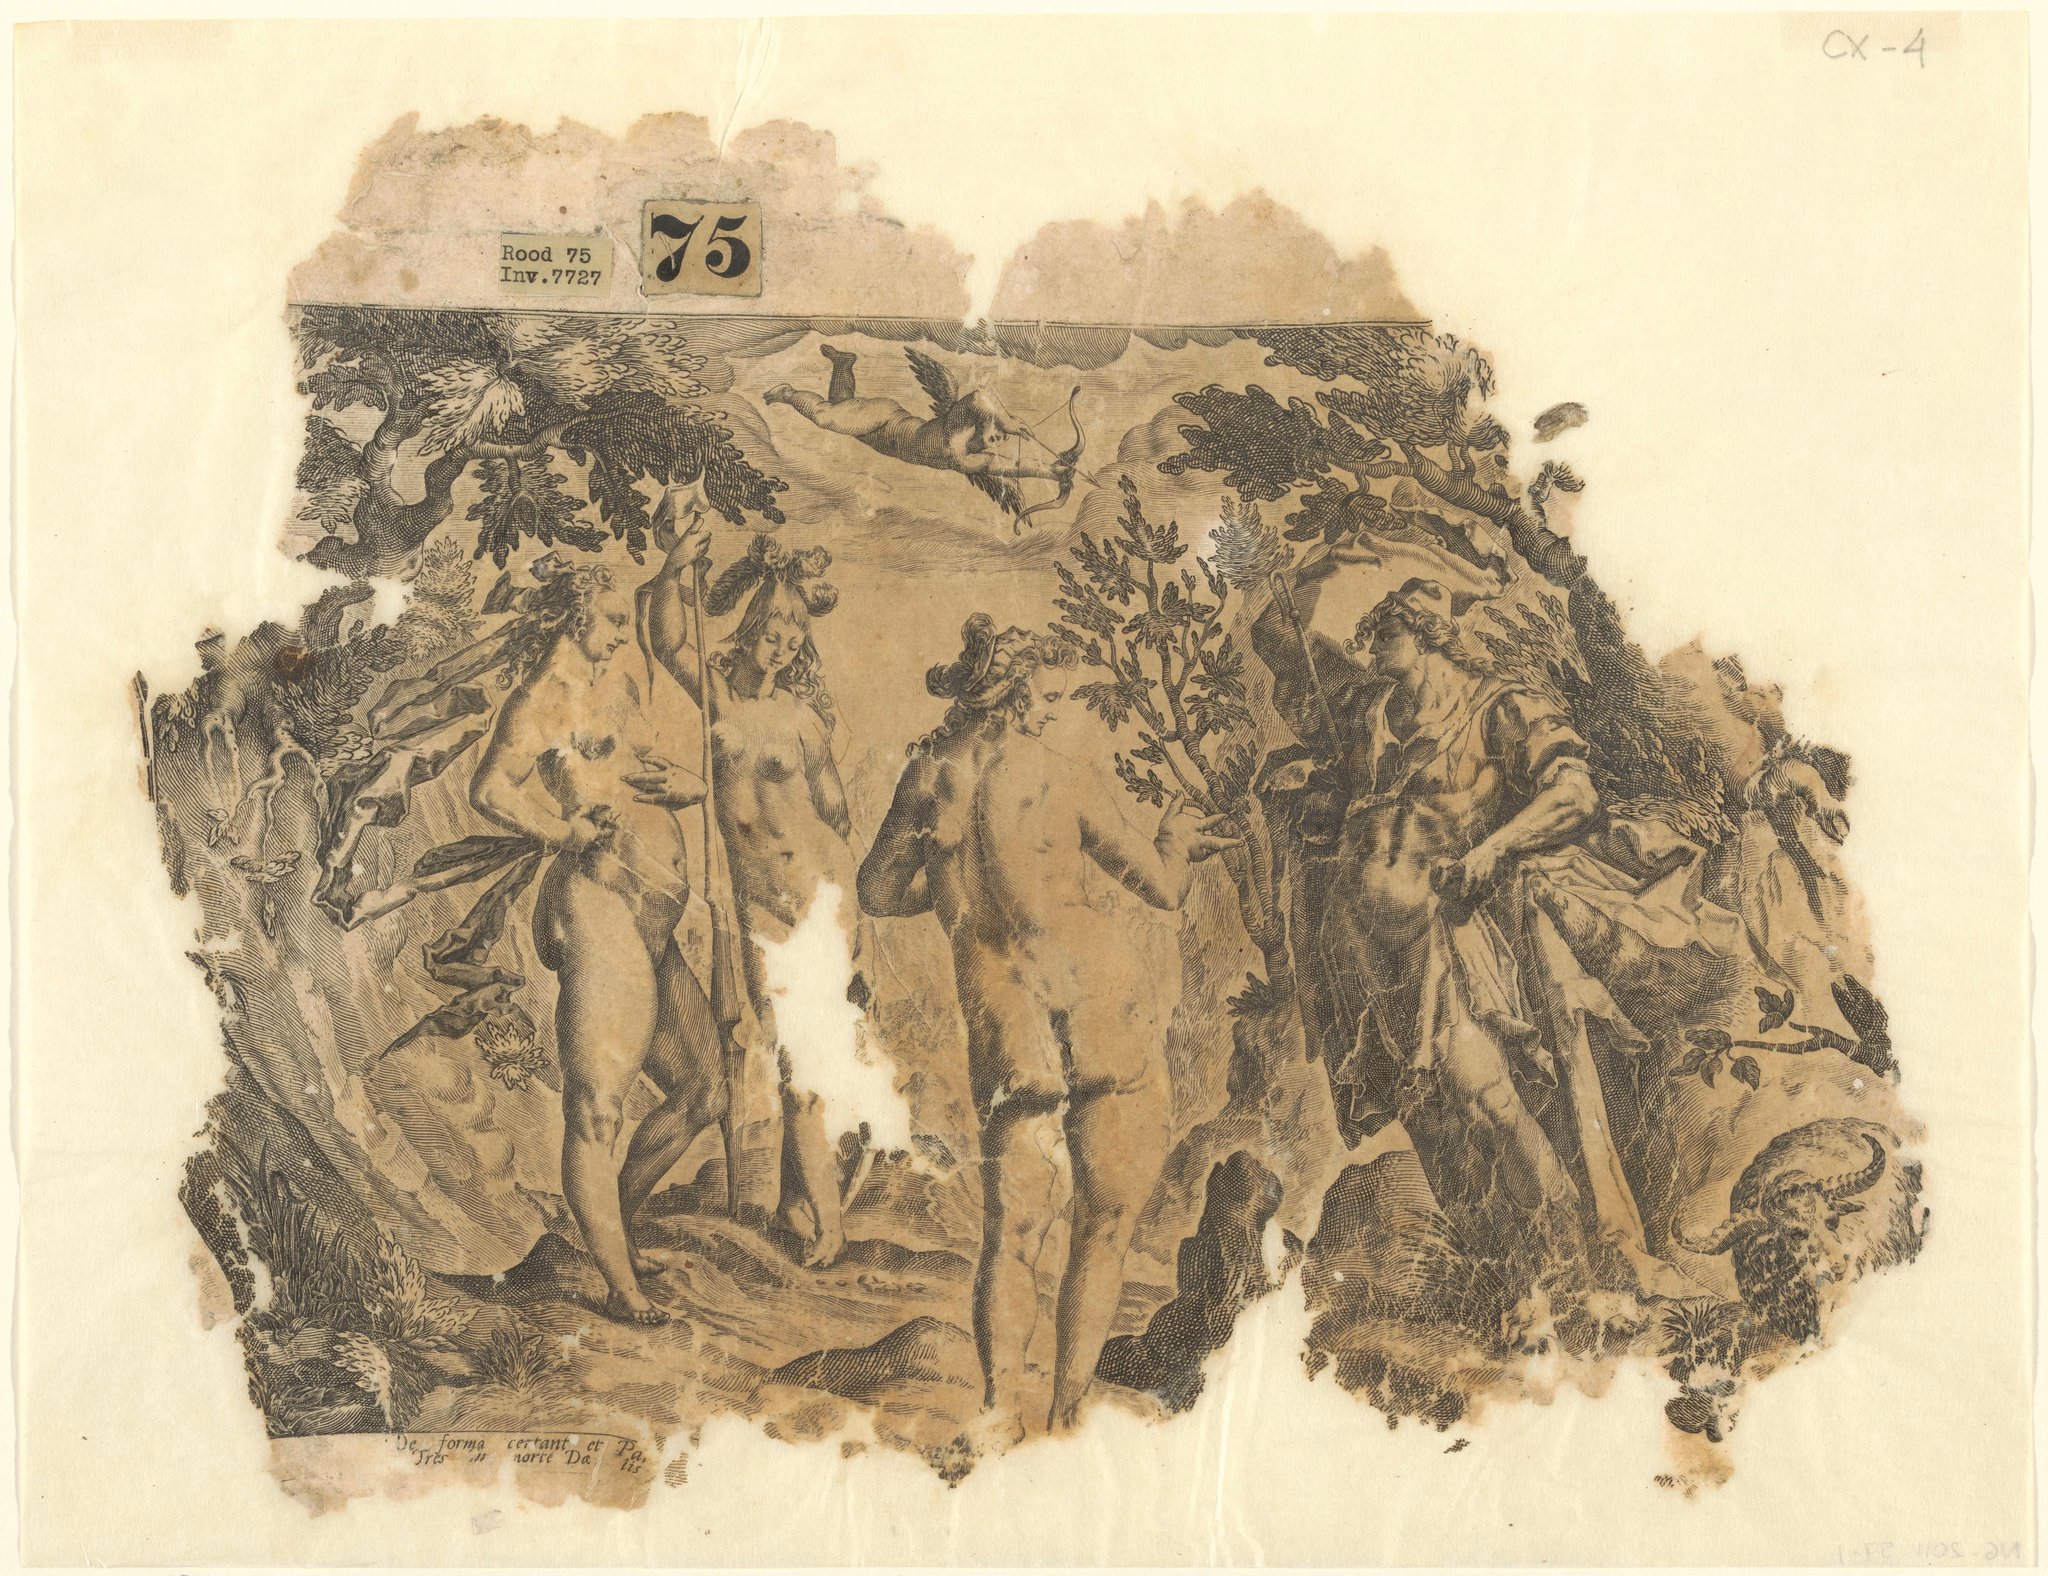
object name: print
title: Oordeel van Paris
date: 1580-1596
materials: paper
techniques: engraving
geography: amsterdam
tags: the judgement of paris (mercury present)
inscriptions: inscription: ‘Rood 75 / Inv. 7727’, inscription: ‘75’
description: De prenten in de Nova Zembla collectie zijn tijdens een expeditie van Willem Barendsz en Jacob van Heemskerk in 1596-1597 noodgedwongen in het winterkamp, het ‘Behouden Huis’, op het eiland achtergelaten. De prenten waren in één of meerdere stapels als handelswaar meegenomen vanuit Amsterdam. Bijna drie eeuwen later, in 1871, keerde de Noor Elling Carlsen terug naar Nova Zembla en vond daar de restanten van het ‘Behouden Huis, inclusief een groot deel van de inventaris. Een deel van de prenten, in de vorm van aaneengekoekte kluiten, werd toen ook teruggevonden. De papierkluiten waren soms op meerdere plekken gebroken. Tussen 1975-1979 zijn de prenten van elkaar gescheiden. Dit leverde in totaal ca. 1000 fragmenten van ca. 400 afdrukken van ca. 150 verschillende prenten op. Voor zover mogelijk zijn de fragmenten samengevoegd en zijn de prenten gereconstrueerd.